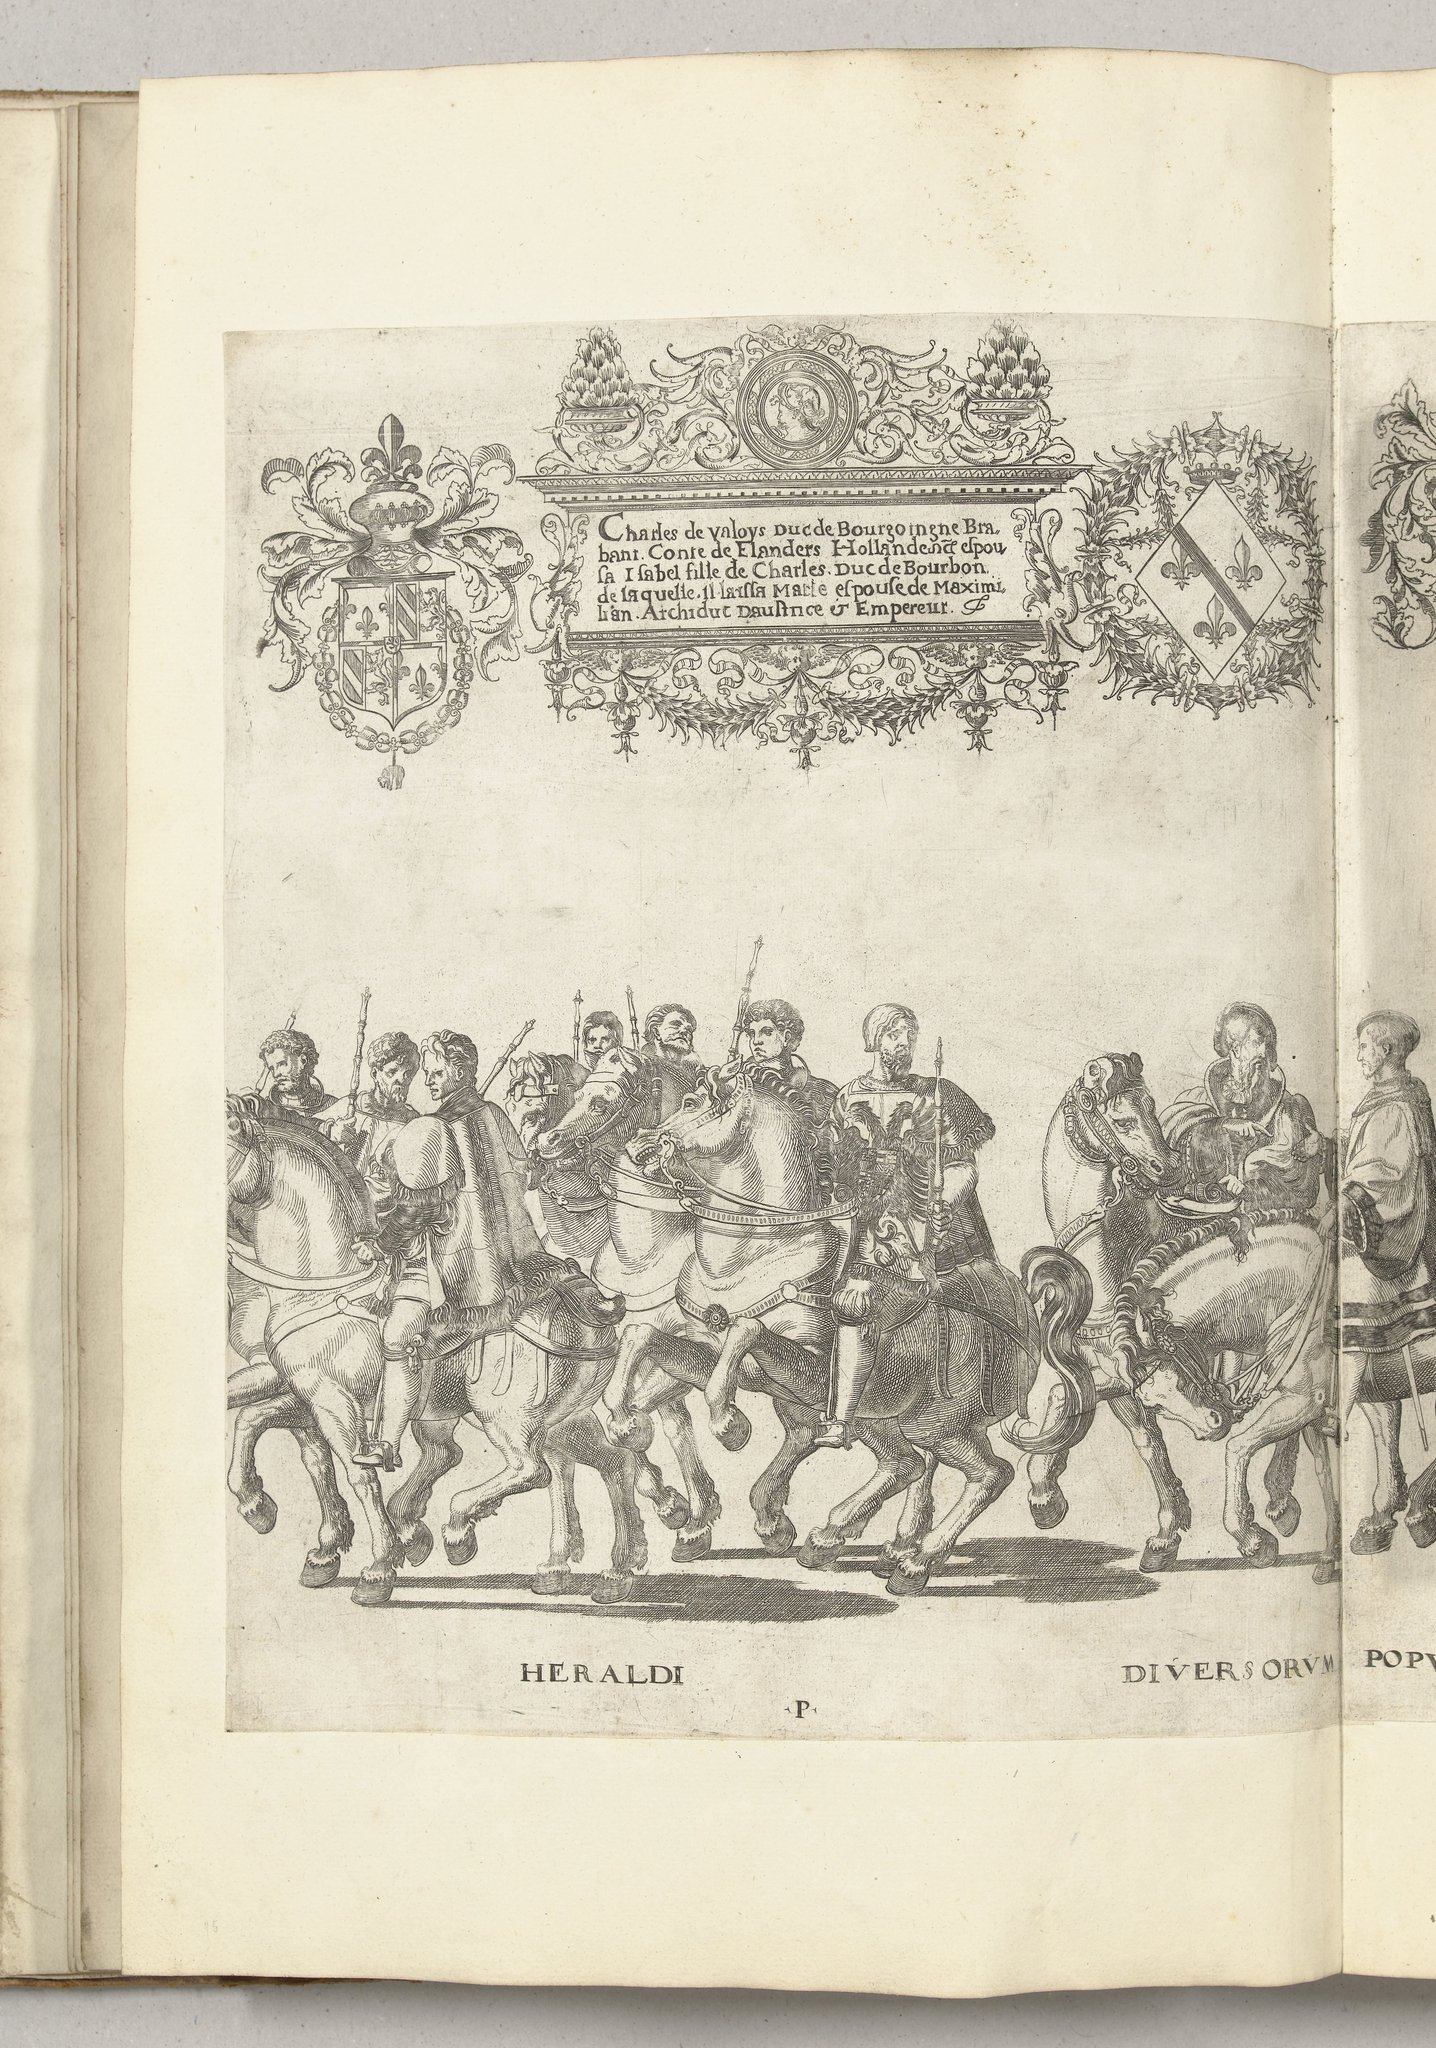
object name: print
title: Optocht van Karel V met de paus te Bologna na zijn kroning to keizer, 1530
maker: nicolaas hogenberg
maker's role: draughtsman, painter, print maker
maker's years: 1500-1539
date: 1530-1536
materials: paper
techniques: etching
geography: mechelen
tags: ghent, charles v (holy roman emperor and king of spain), rome, festivities (+ parade, pageant, cavalcade ~ festive activities)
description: Prent in het album waarin zijn ingeplakt de 40 platen die achterelkaar samen het fries vormen van de optocht van Karel V met de paus Clemens VII te Bologna na zijn kroning tot keizer, 24 februari 1530.